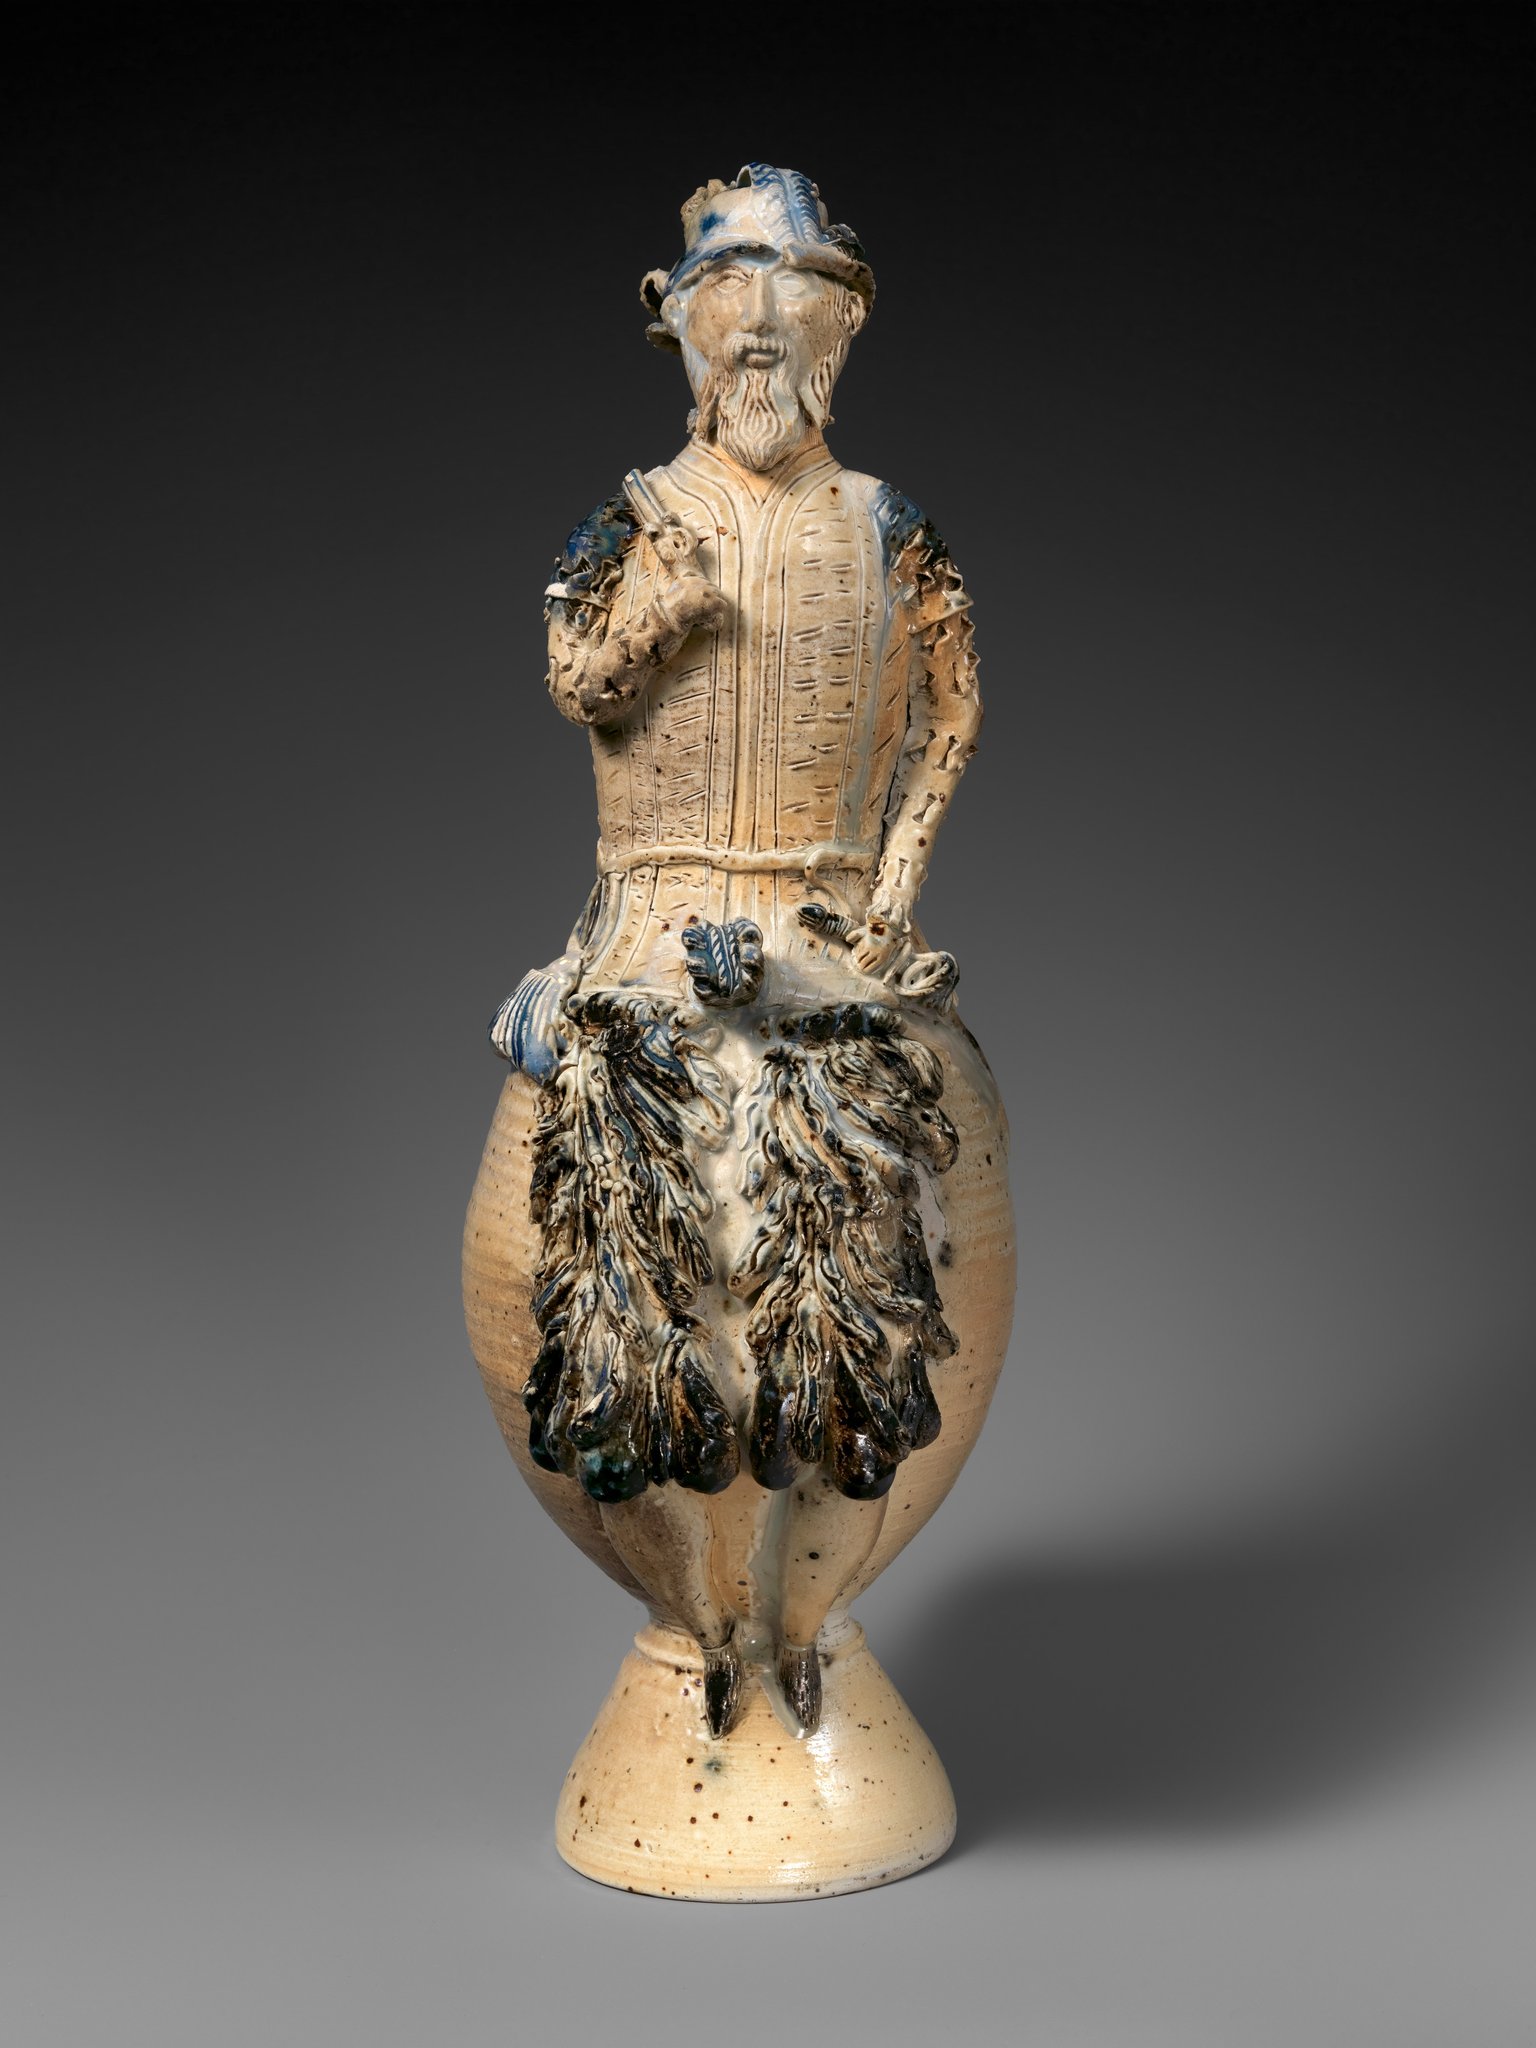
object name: bottom up cup or stirrup cup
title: Bottoms-up cup or stirrup cup (Sturzbecher)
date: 1550-1570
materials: stoneware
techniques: salt glaze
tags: men